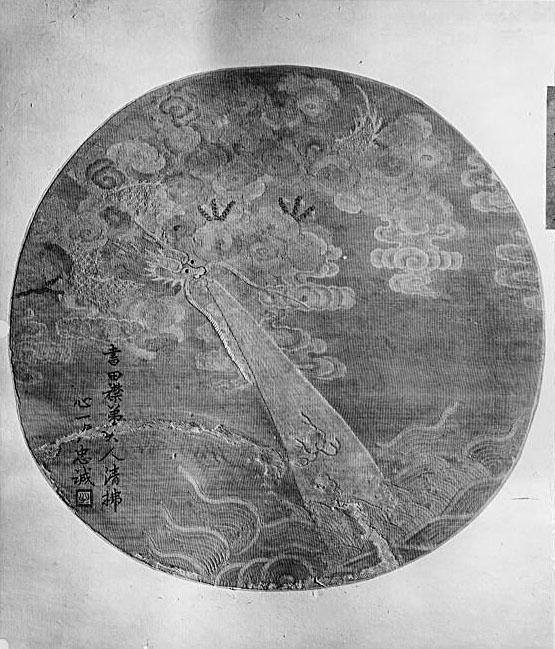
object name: fan surface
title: Fan Surface with a Dragon, Clouds, and Waves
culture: chinese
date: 1368-1644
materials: silk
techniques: tapestry, weave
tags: dragons,waves,clouds